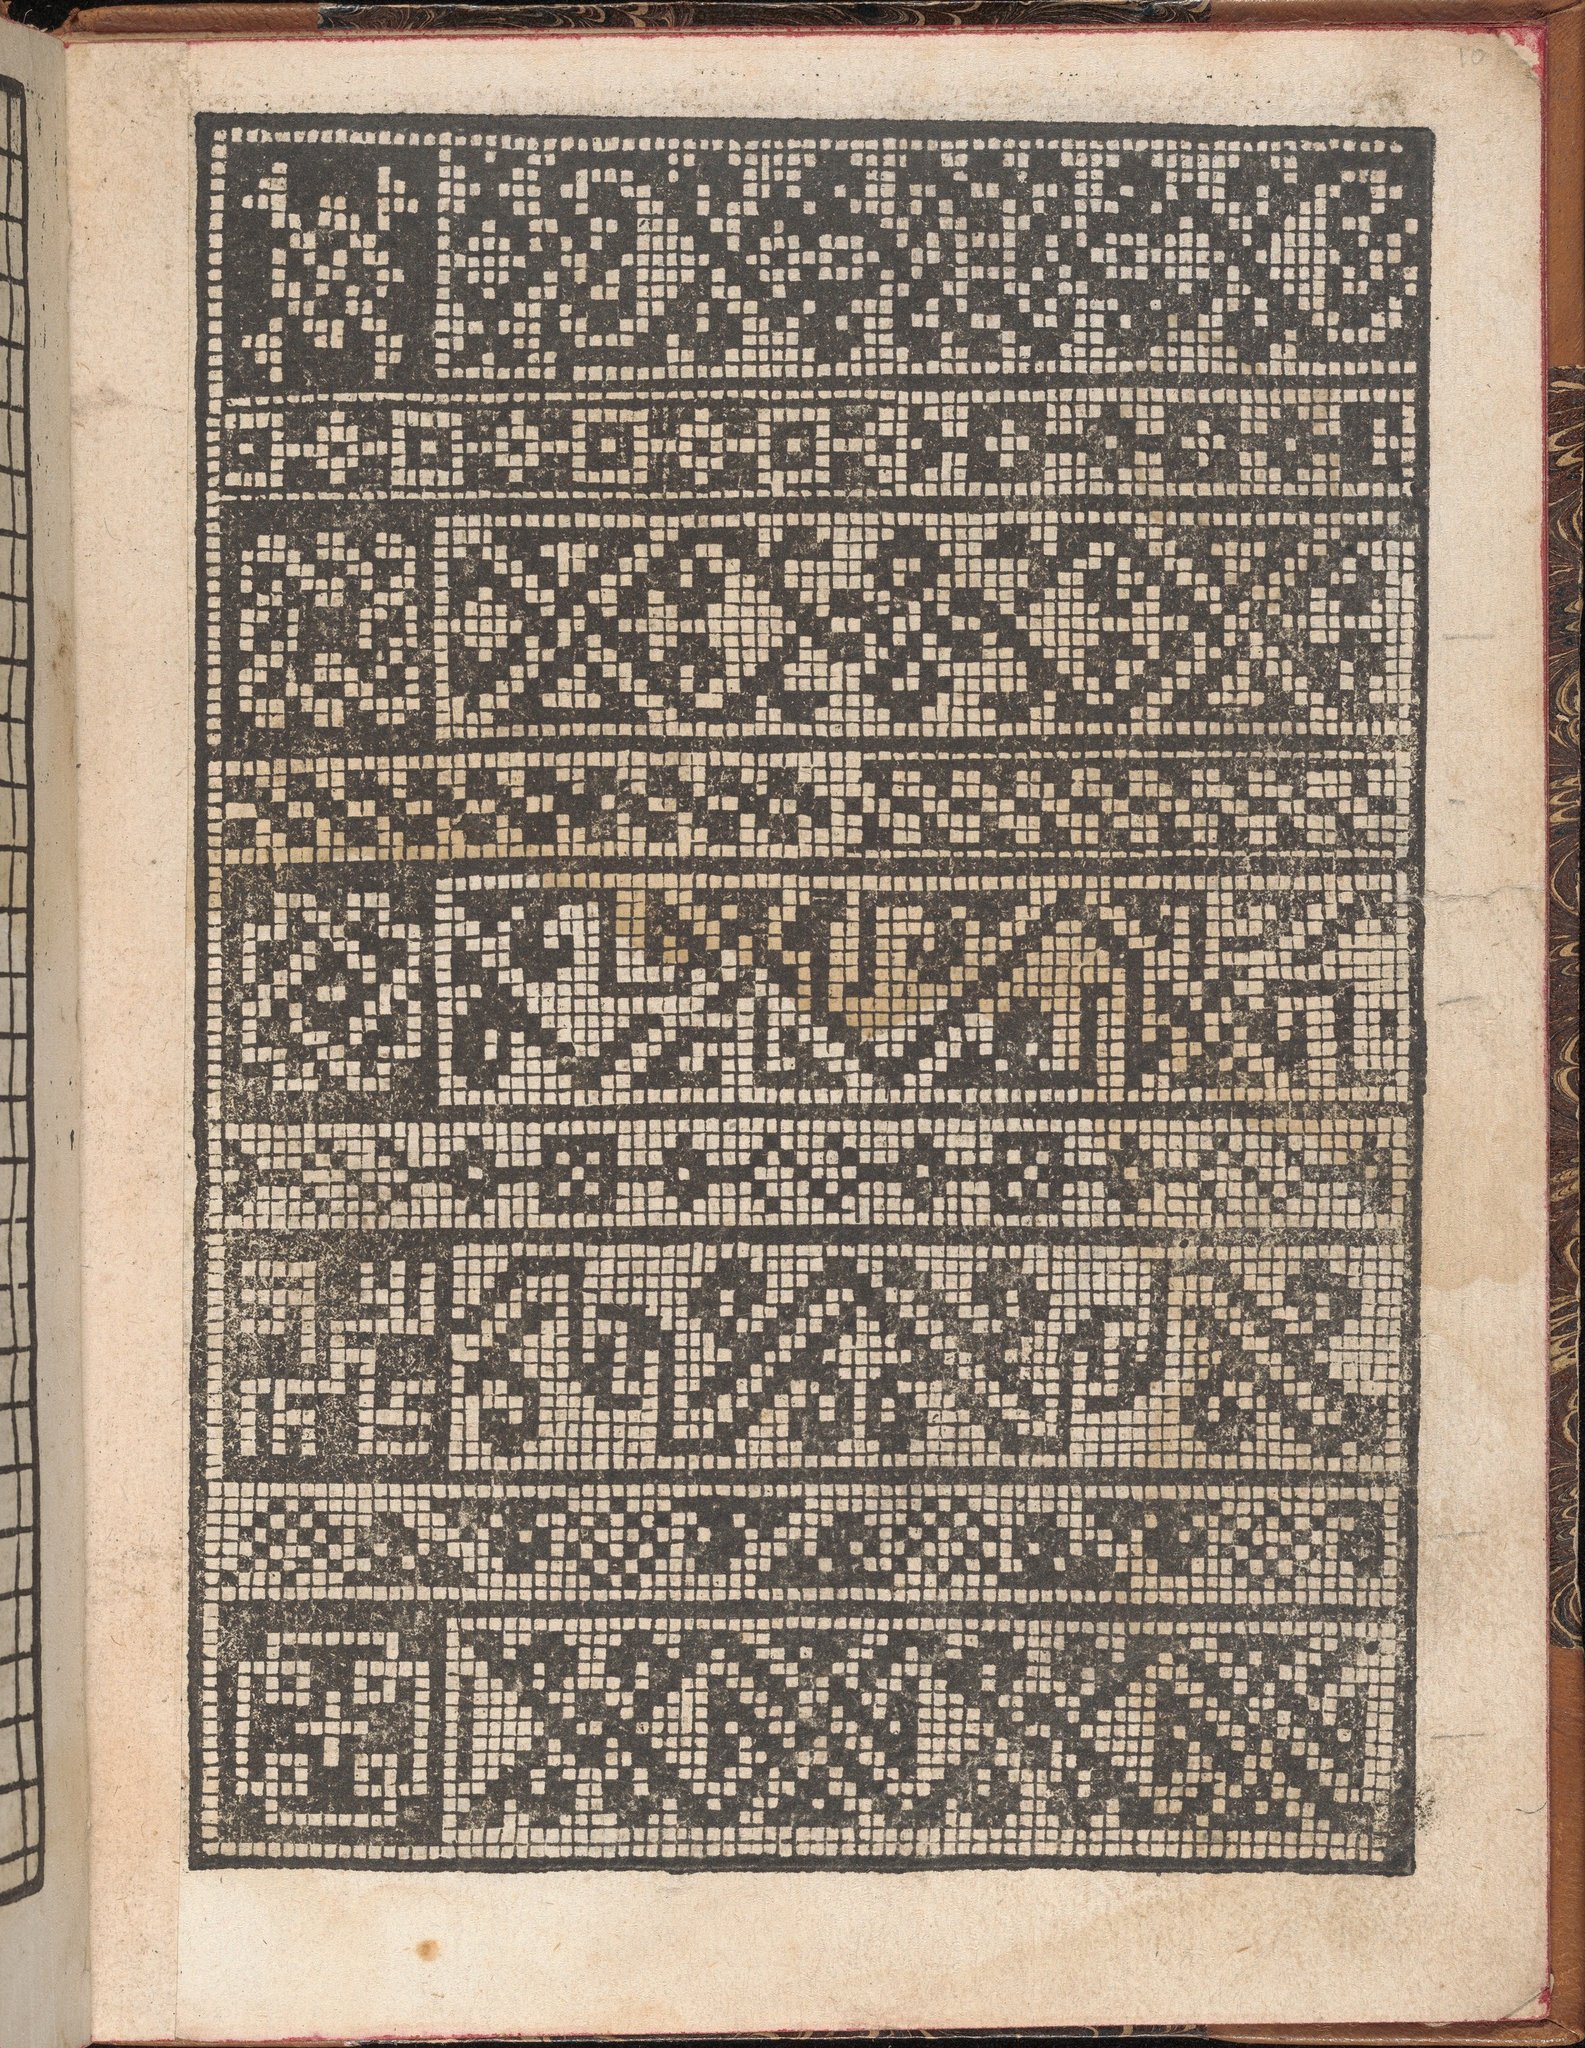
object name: book print ornament architecture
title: Spechio di pensieri delle belle et Virtudiose donne, page 10 (recto)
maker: matteo pagano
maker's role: publisher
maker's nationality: italian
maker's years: 1515-1588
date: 1546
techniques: woodcut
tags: ornament